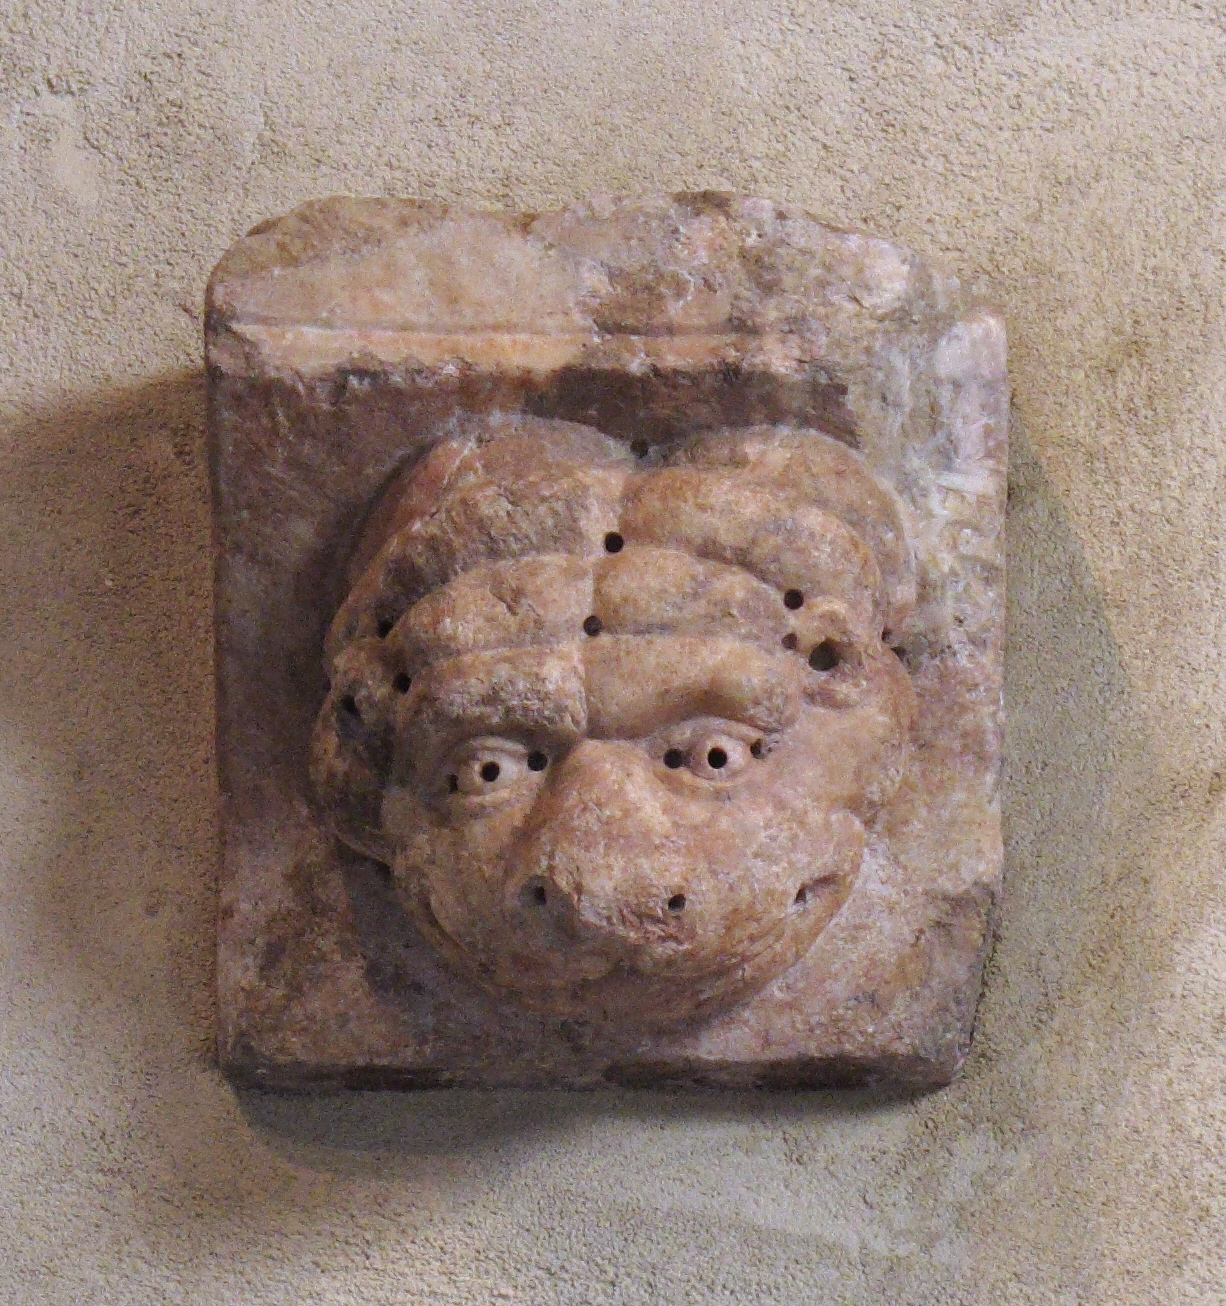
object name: corbel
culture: catalan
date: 1130-1140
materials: marble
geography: france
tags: lions